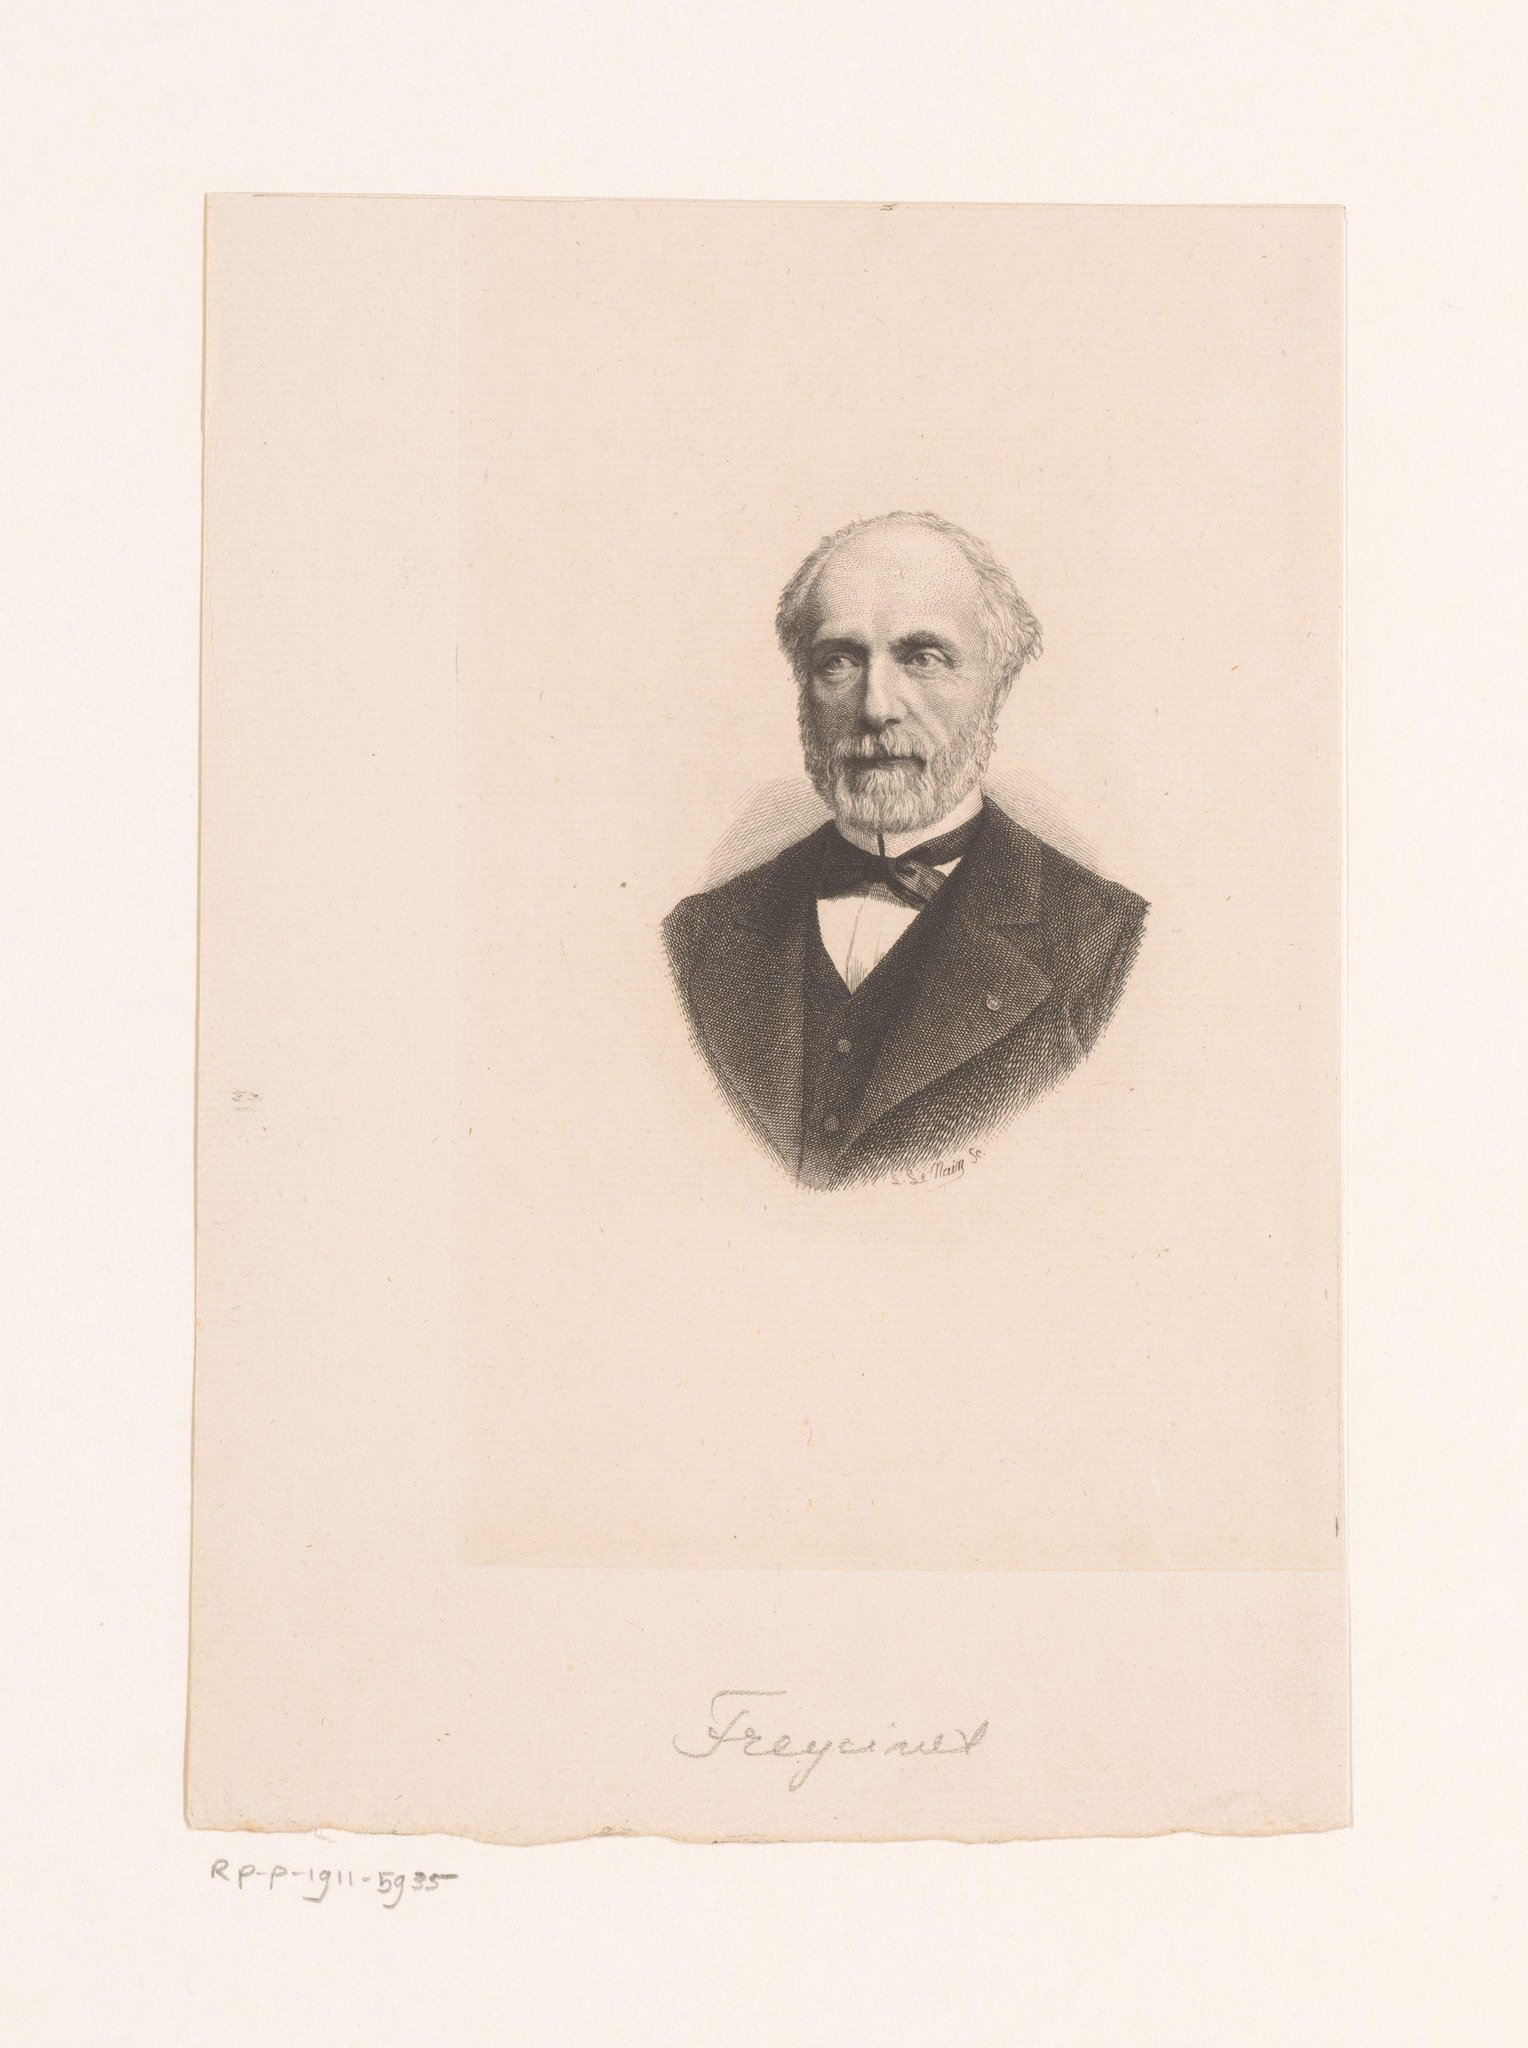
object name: print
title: Portret van Charles de Freycinet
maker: louis le nain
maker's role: print maker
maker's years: 1851-1939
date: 1861-1911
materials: paper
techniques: etching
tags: adult man, historical persons, beard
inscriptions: collector's mark: Lugt 2228